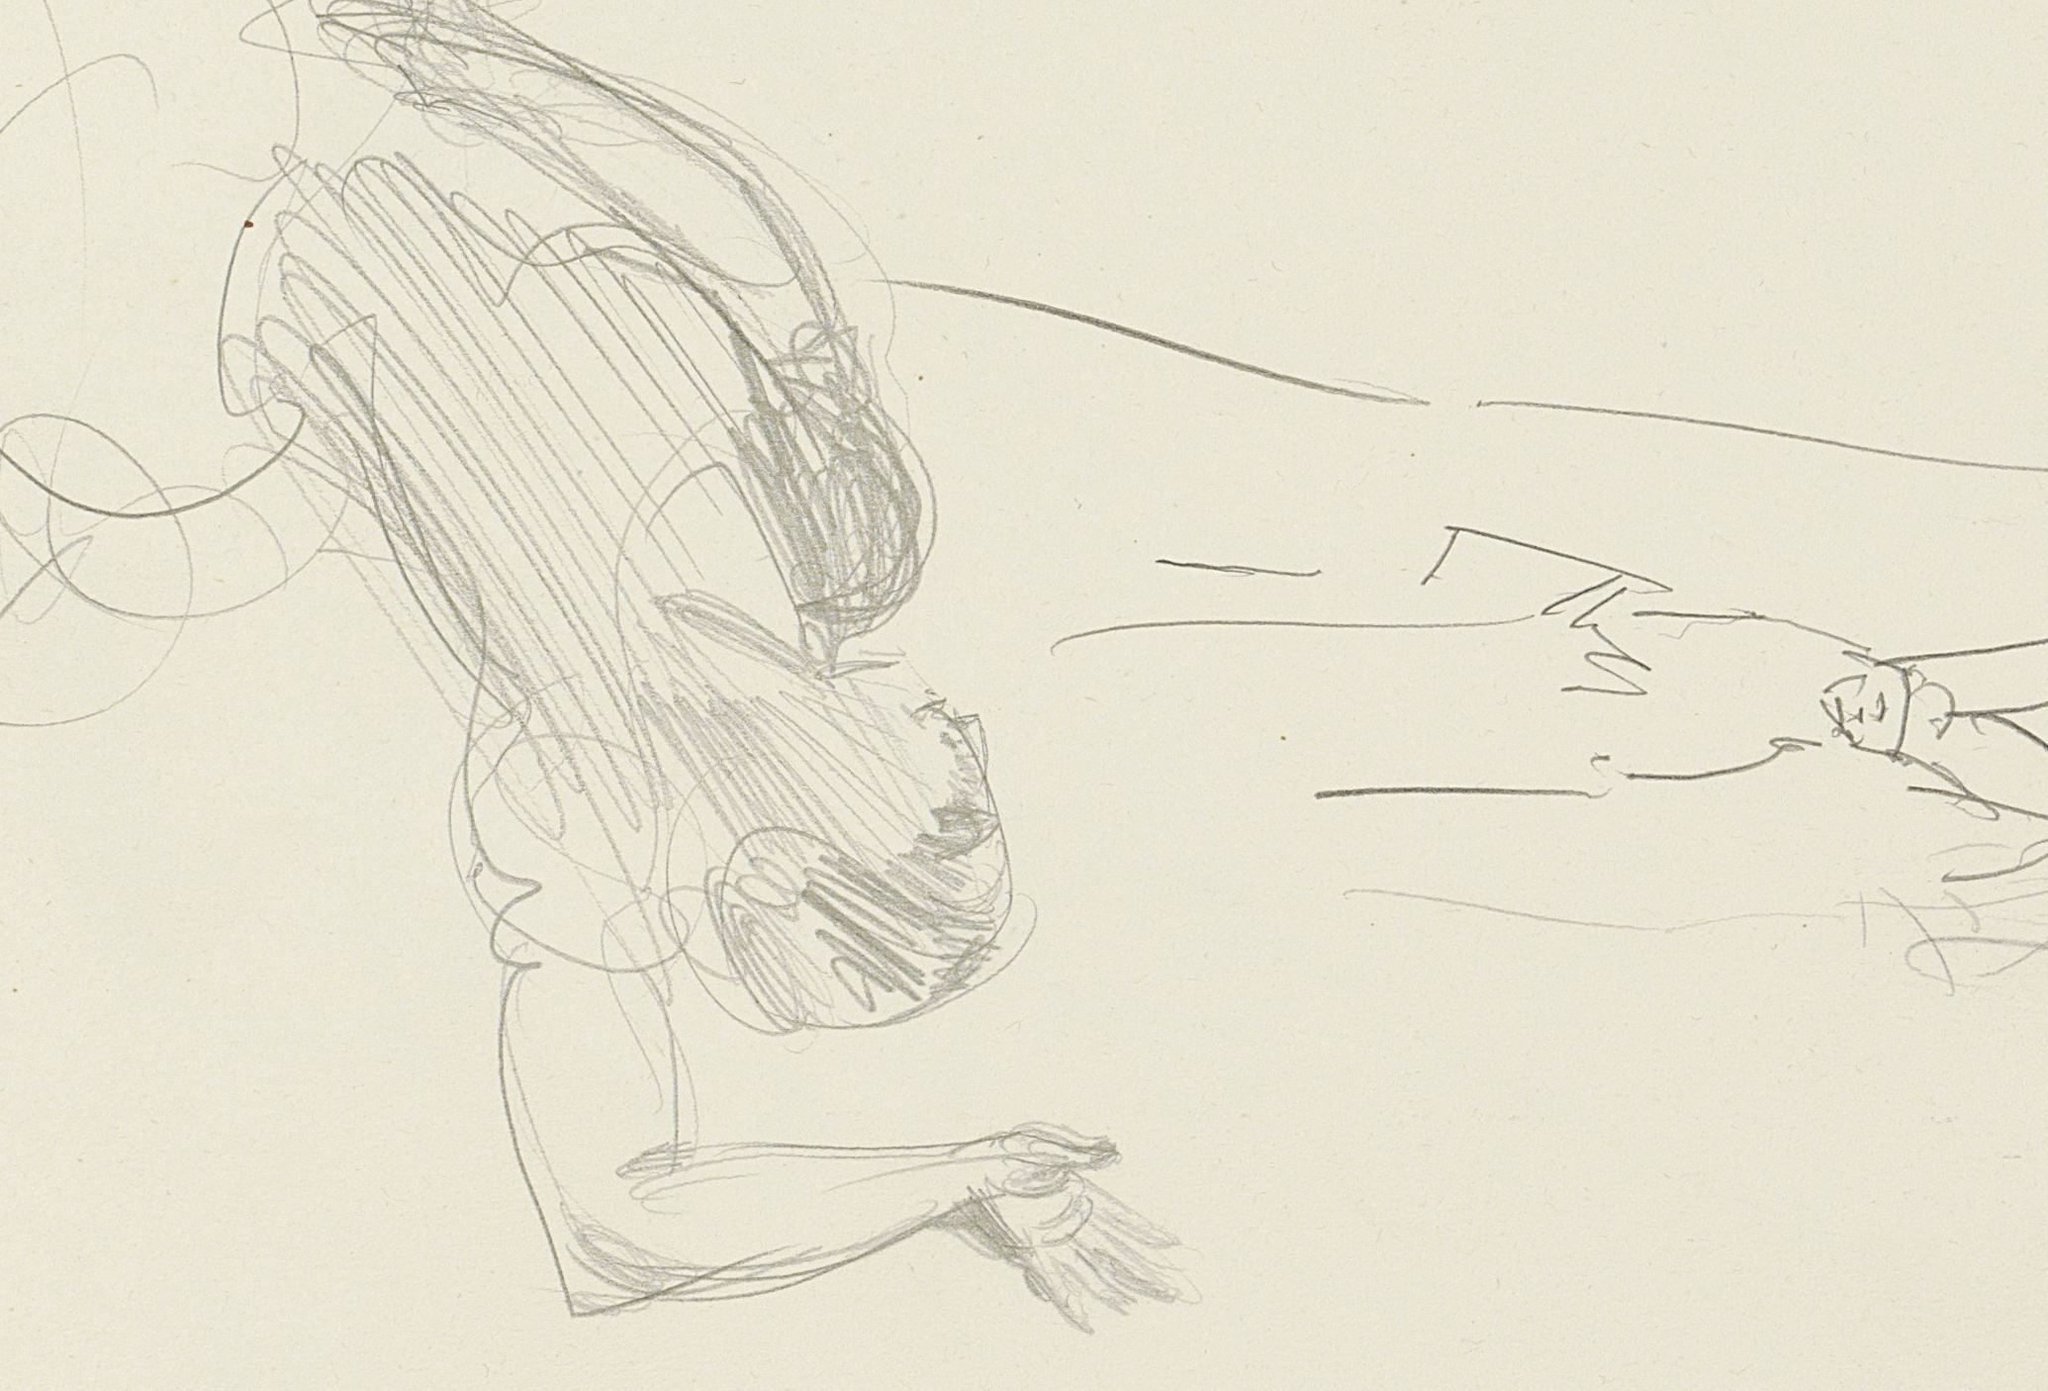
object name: sketchbook leaf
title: Danseres op het toneel, in profiel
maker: isaac israels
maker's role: draughtsman, painter, print maker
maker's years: 1865-1934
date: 1875-1934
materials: paper, pencil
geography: the hague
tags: adult woman (+ sideview, profile), female dancer, the stage and its equipment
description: Op de achtergrond verklede figuren, mogelijk tussen de coulissen. Blad 10 verso uit schetsboek XXVIII met 17 bladen.